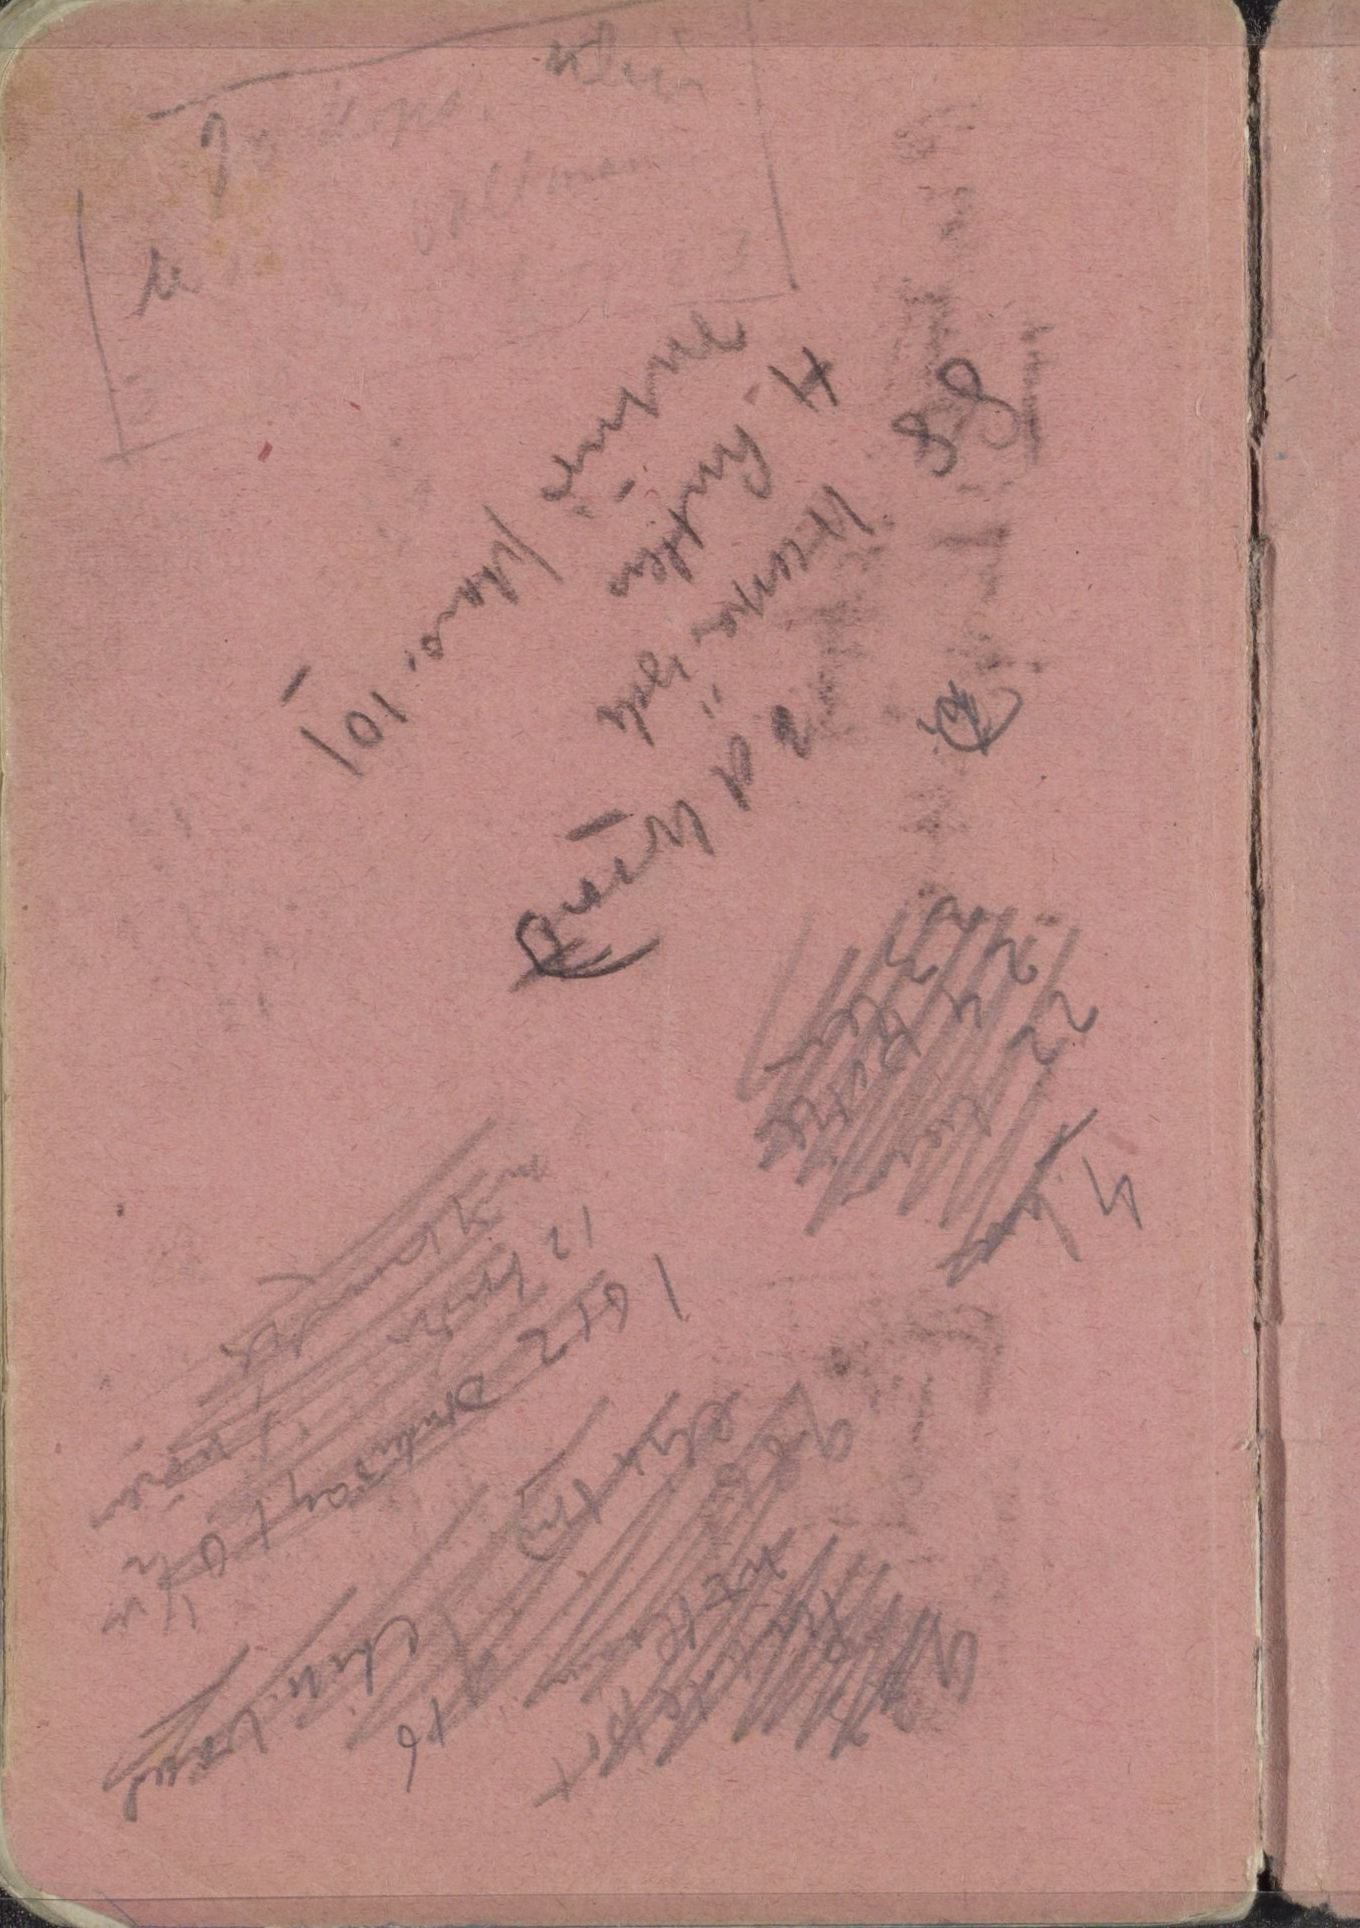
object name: sketchbook leaf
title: Annotaties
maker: george hendrik breitner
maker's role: draughtsman, painter, print maker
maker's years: 1857-1923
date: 1898-1902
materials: chalk, paper, pencil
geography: amsterdam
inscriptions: annotation: ‘[...]’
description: Pagina 85, vrij schutblad, uit een schetsboek met 42 bladen.